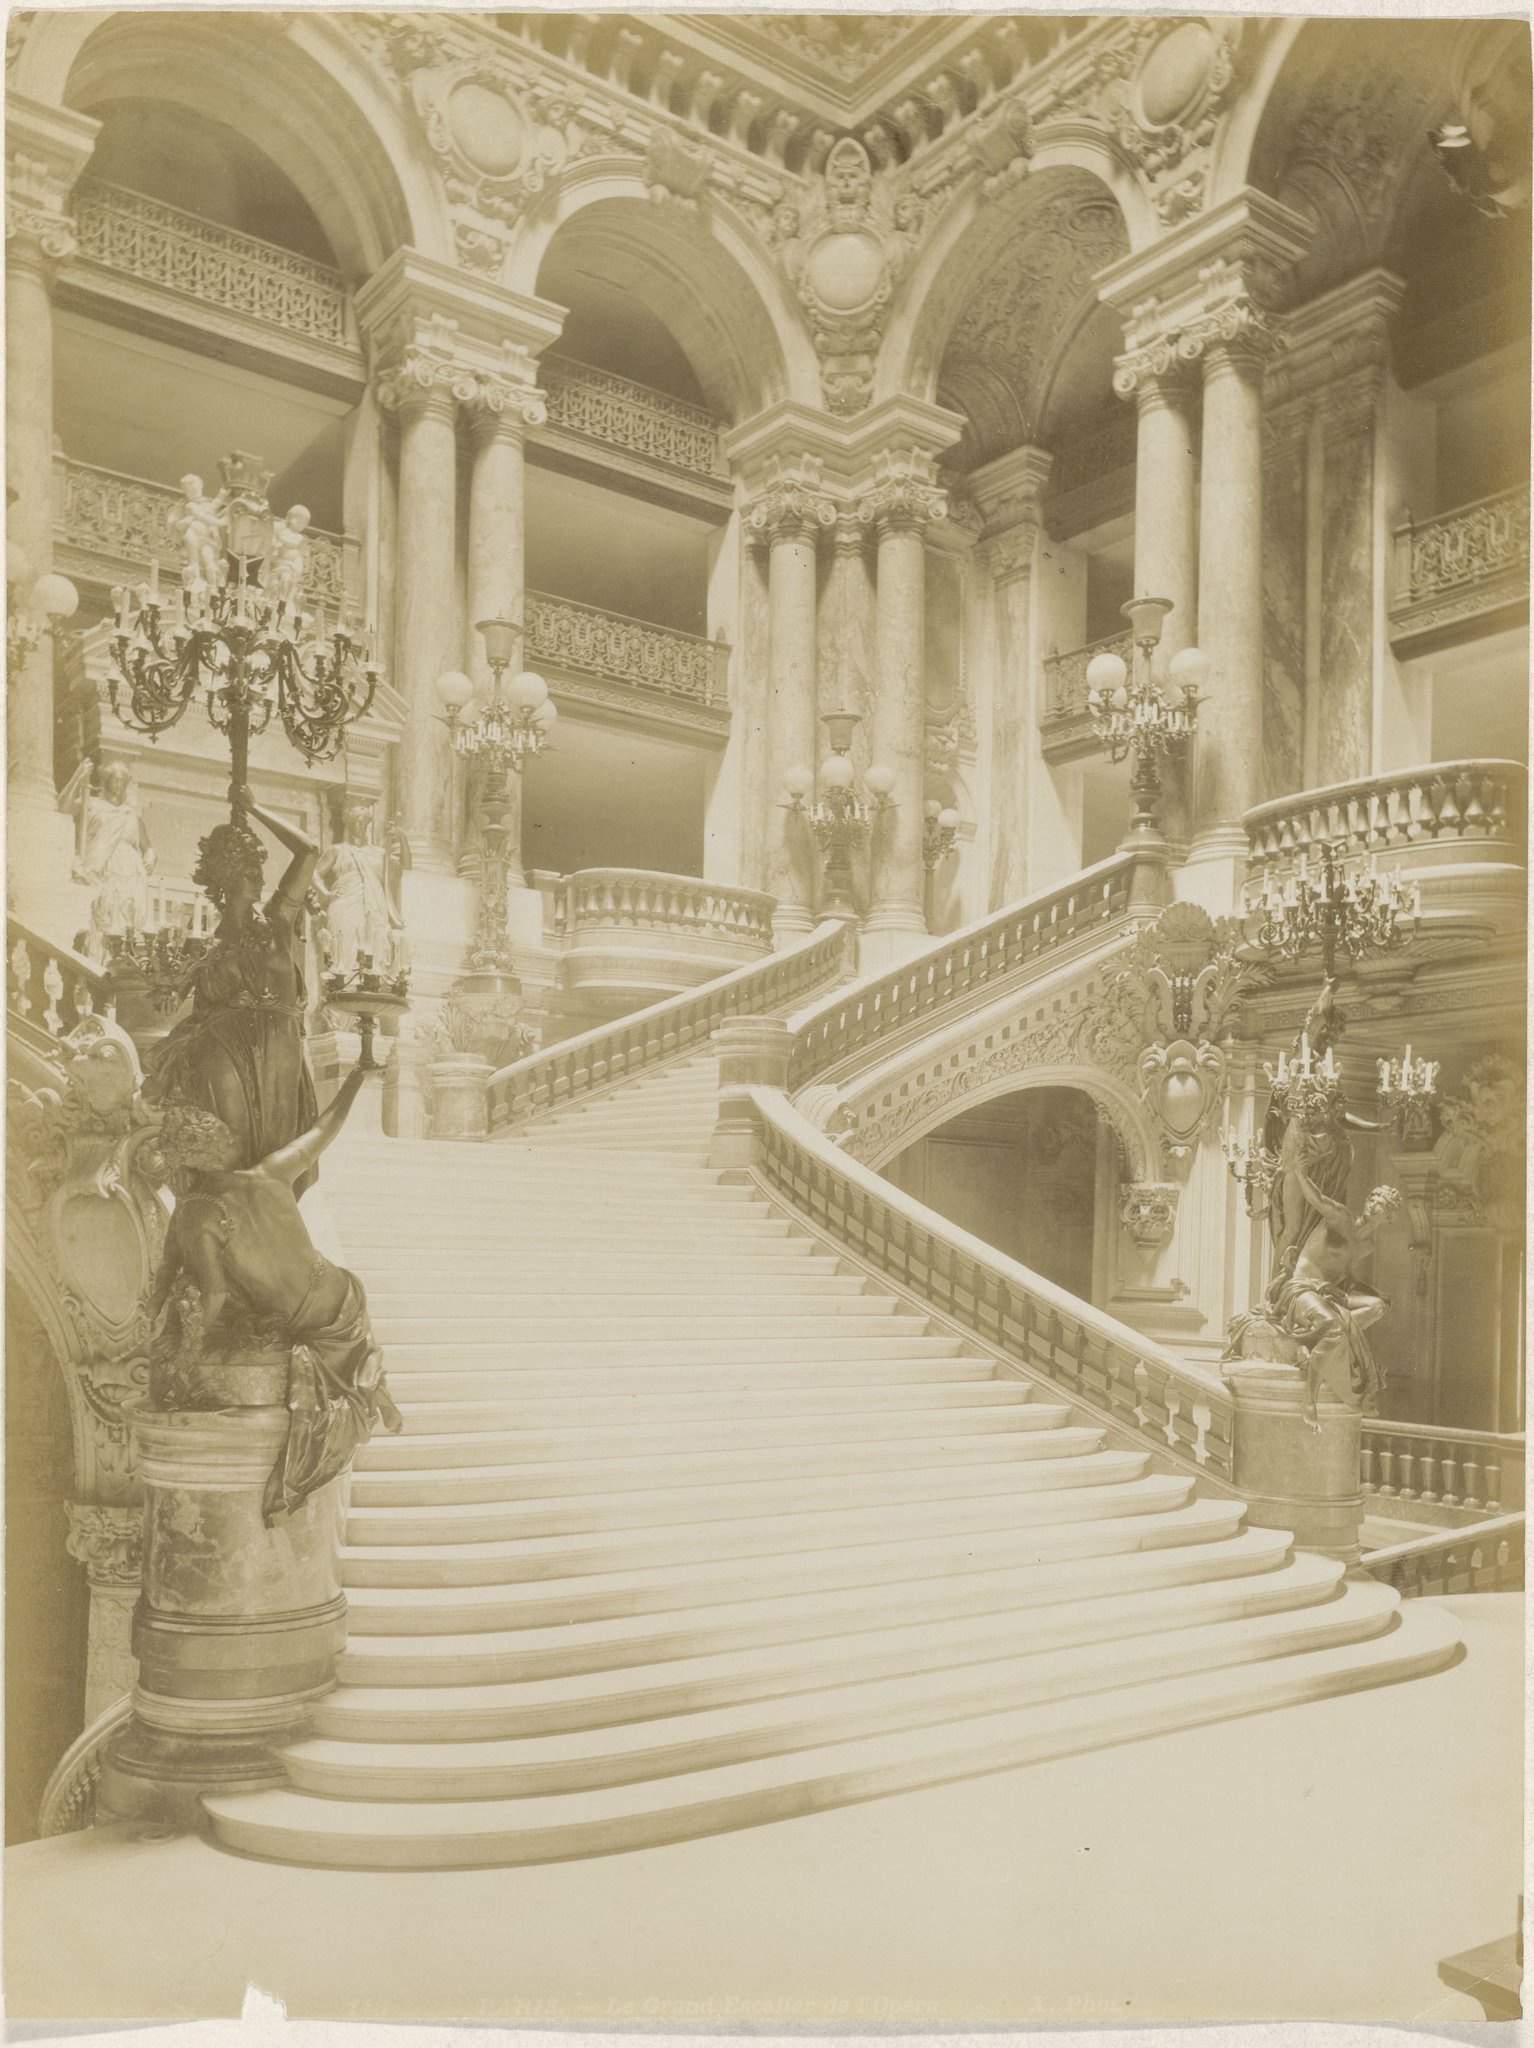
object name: photograph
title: Paris. - Le Grand Escalier de l'Opéra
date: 1887-1900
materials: paper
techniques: albumen print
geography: paris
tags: staircase, opera house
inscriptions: inscription: ‘148 Paris. - Le Grand Escalier de l'Opéra X. Phot.’, inscription: ‘Parijs -Opera’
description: Tussen 1887 en ca. 1900 werkten Neurdein frères onder andere onder de naam 'X phot.'.